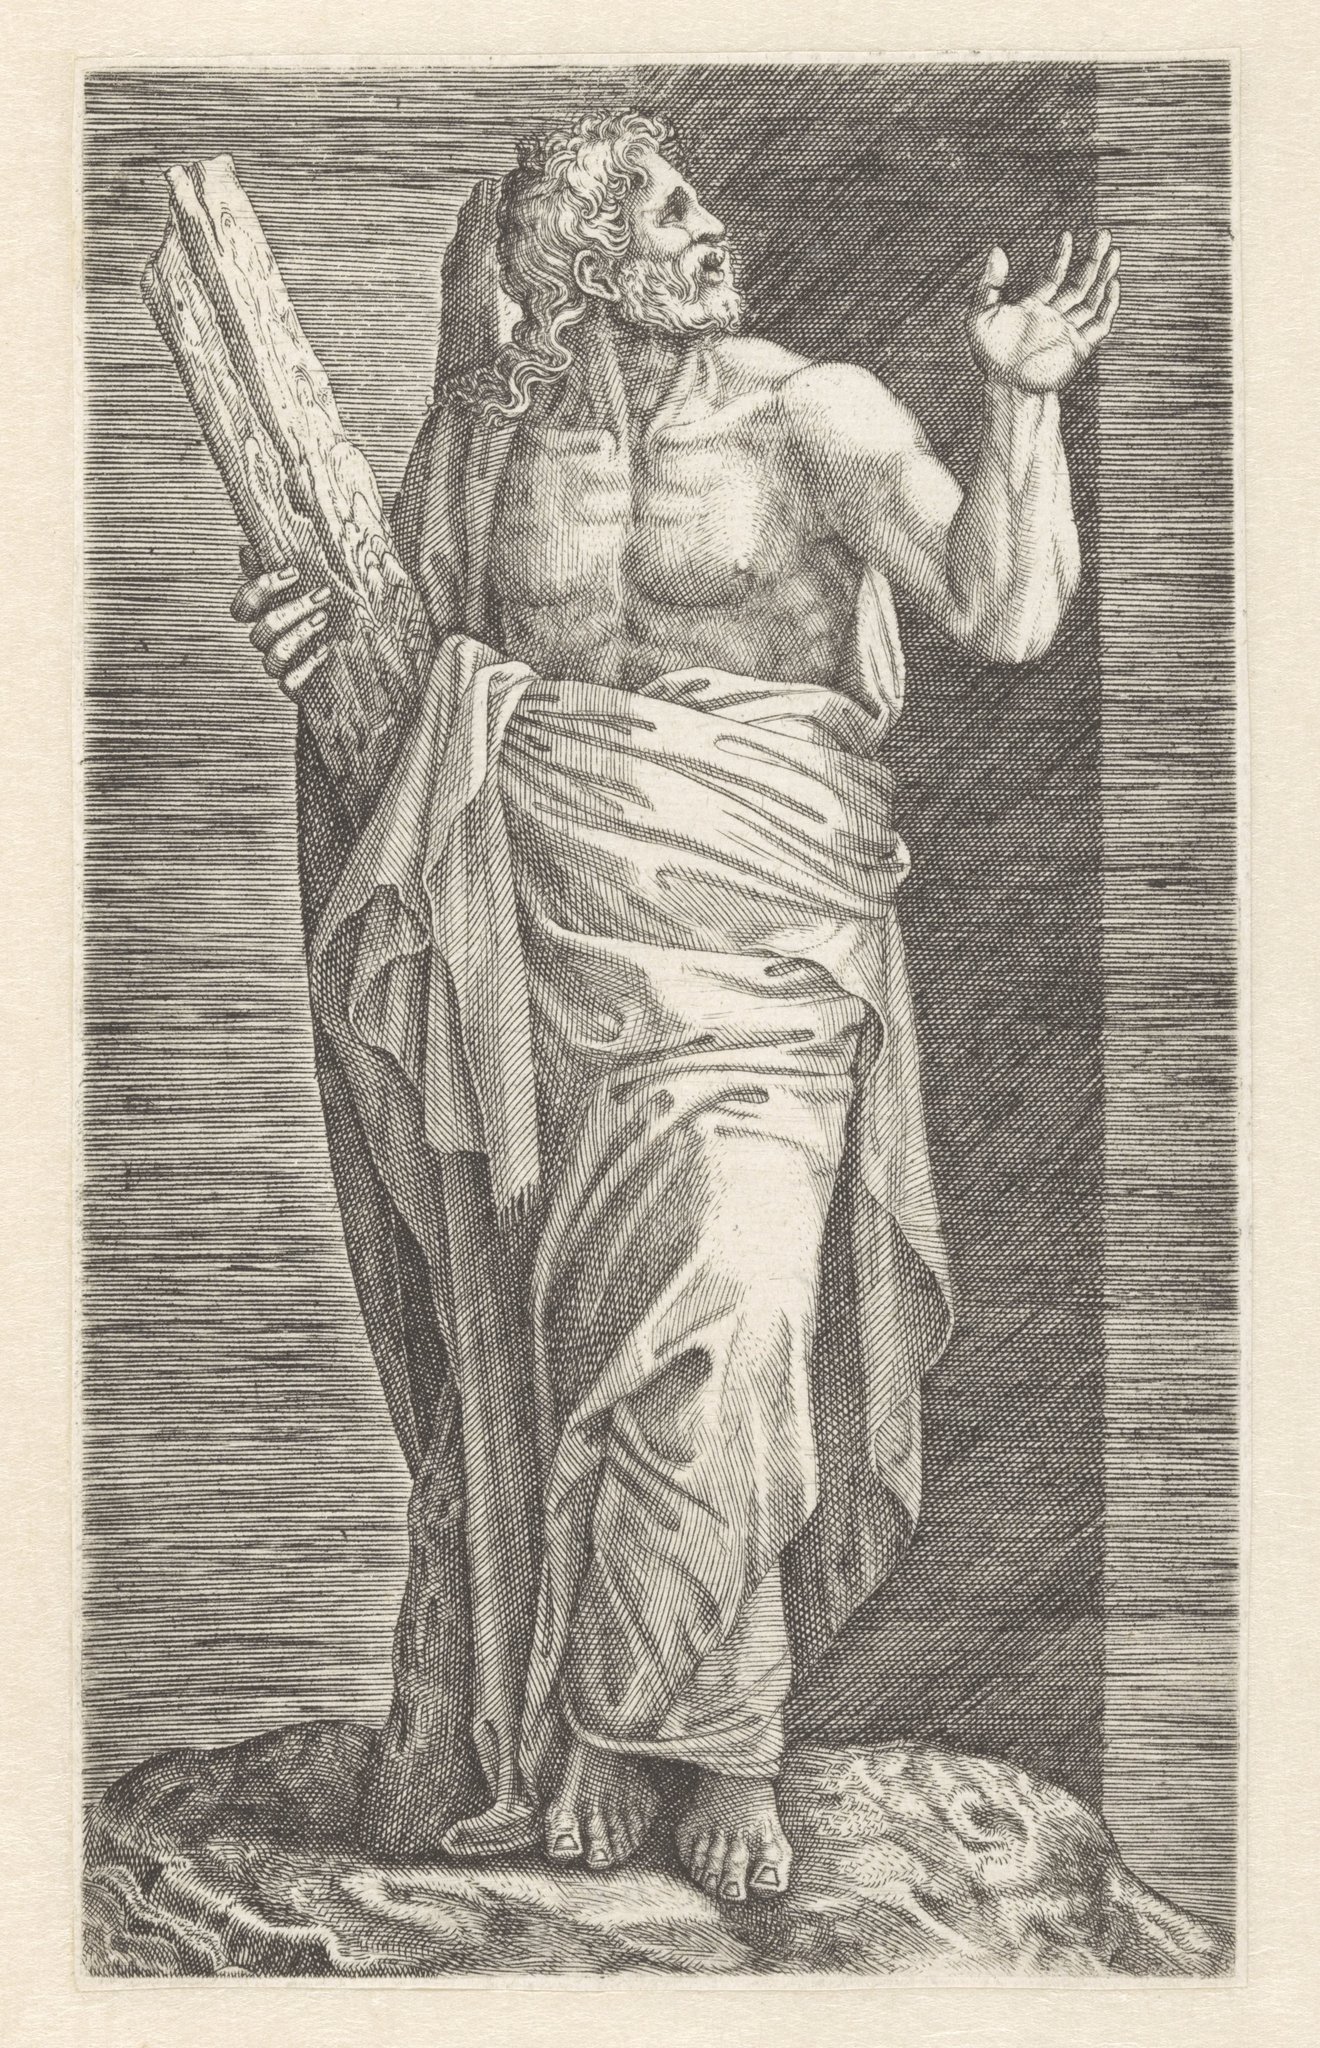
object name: print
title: Andreas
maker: Anonymous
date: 1555-1565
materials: paper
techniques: engraving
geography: netherlands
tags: the apostle andrew; possible attributes: book, x-shaped cross, fish, fishing-net, rope, scroll, adult christ together with apostles, evangelists, saints, etc., the twelve apostles (as a group), usually with books or scrolls (not in biblical context)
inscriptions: collector's mark: Lugt 2228, collector's mark: Lugt 2760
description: Slechts één andere, complete serie bekend: in de Koninklijke Bibliotheek te Brussel. Proefdrukken, vóór de opschriften van de namen van Christus en de apostelen.